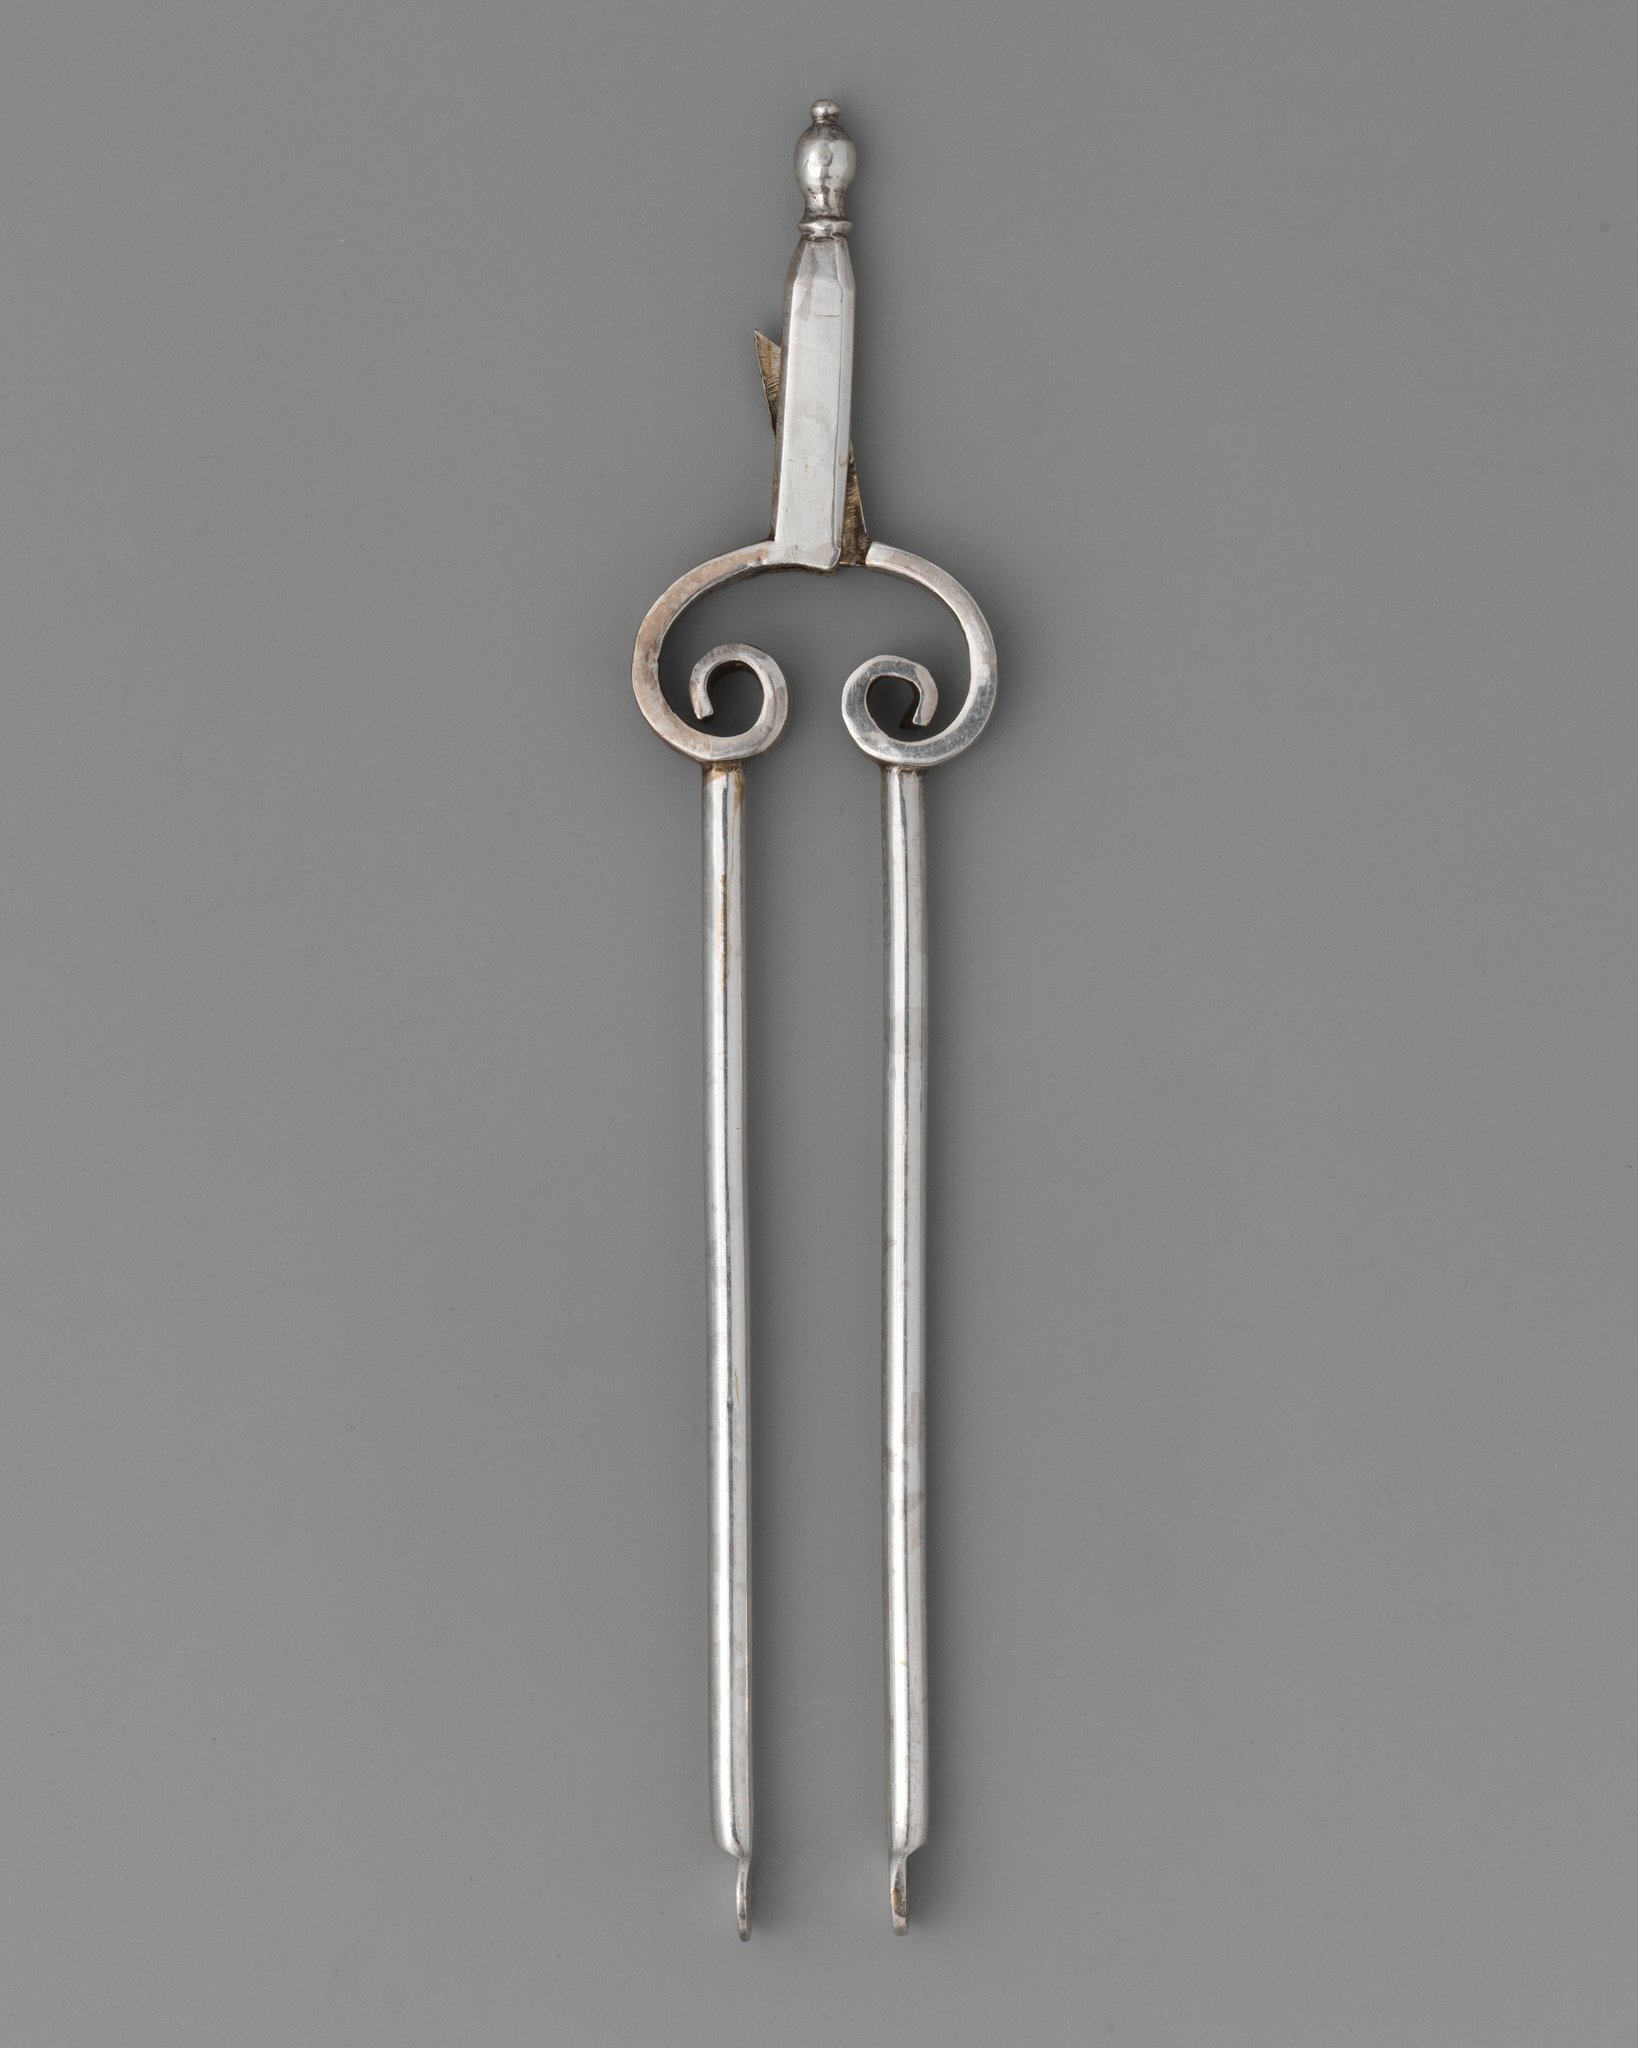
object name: tongs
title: Miniature tongs (part of a set)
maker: david clayton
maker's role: artist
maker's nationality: british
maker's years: 1659-1719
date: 1720-1730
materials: silver